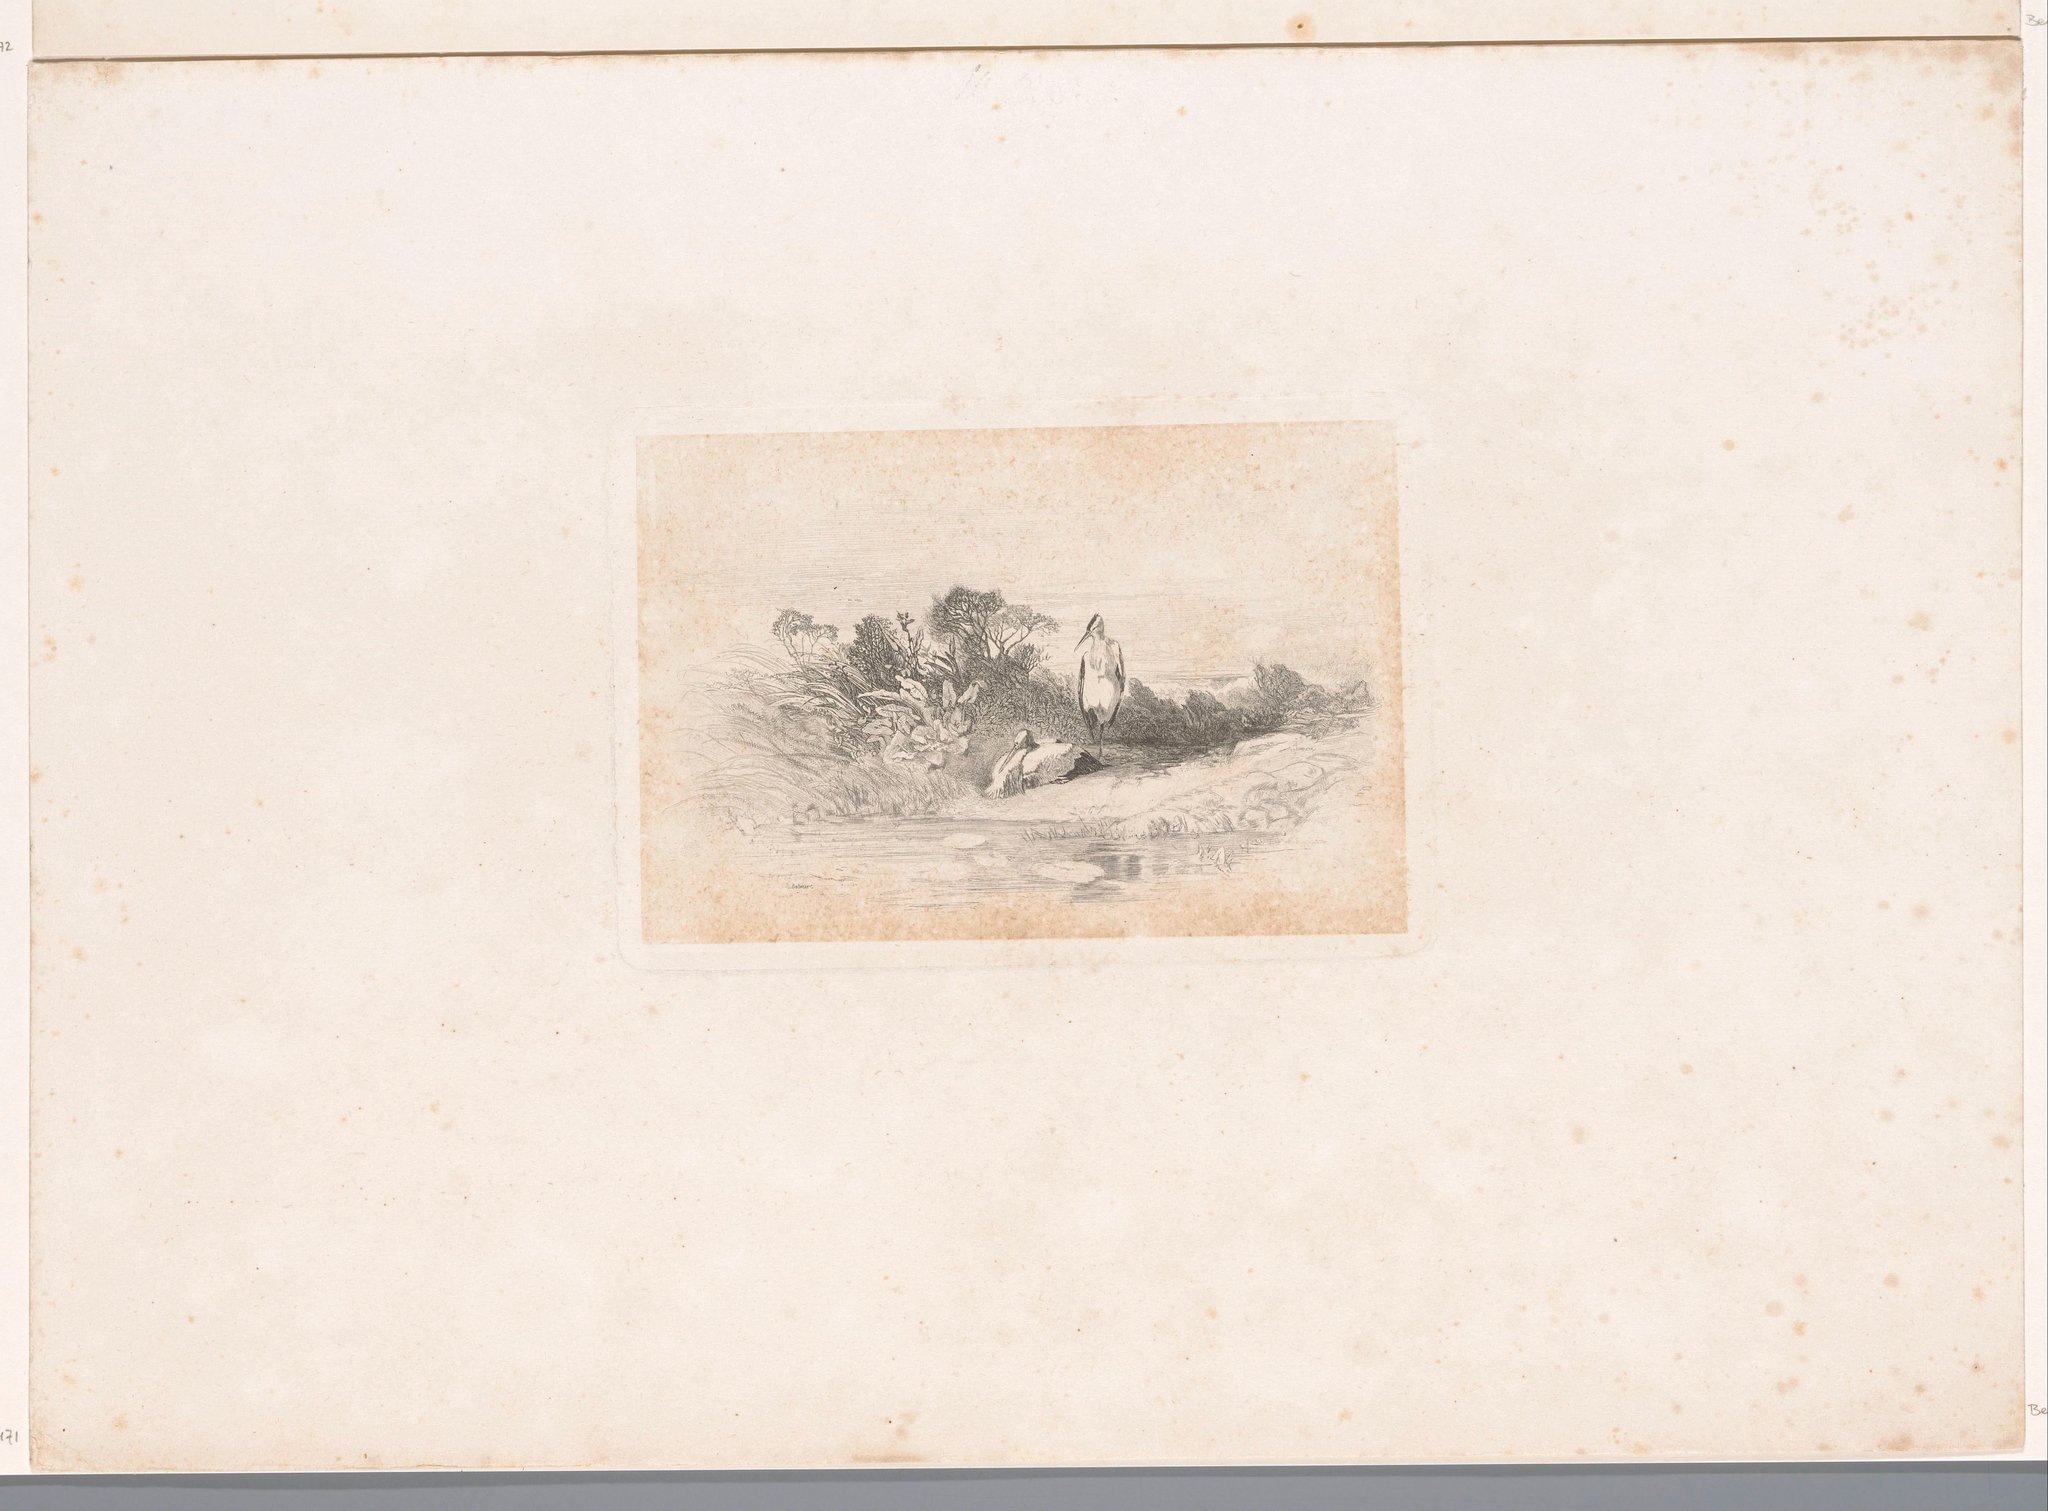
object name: print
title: Twee reigers aan de waterkant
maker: karl bodmer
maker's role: draughtsman, painter, print maker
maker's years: 1809-1893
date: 1847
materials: paper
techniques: etching, roulette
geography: paris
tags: shore-birds and wading-birds: heron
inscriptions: collector's mark: Lugt 2228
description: Zesde prent uit een serie bestaand uit twaalf landschappen met dieren. De prenten vormen waarschijnlijk een uitwerking van de tekeningen die Bodmer maakte tijdens een expeditie door Noord-Amerika (1832-1834), onder leiding van prins Maximilian zu Wied-Neuwied.